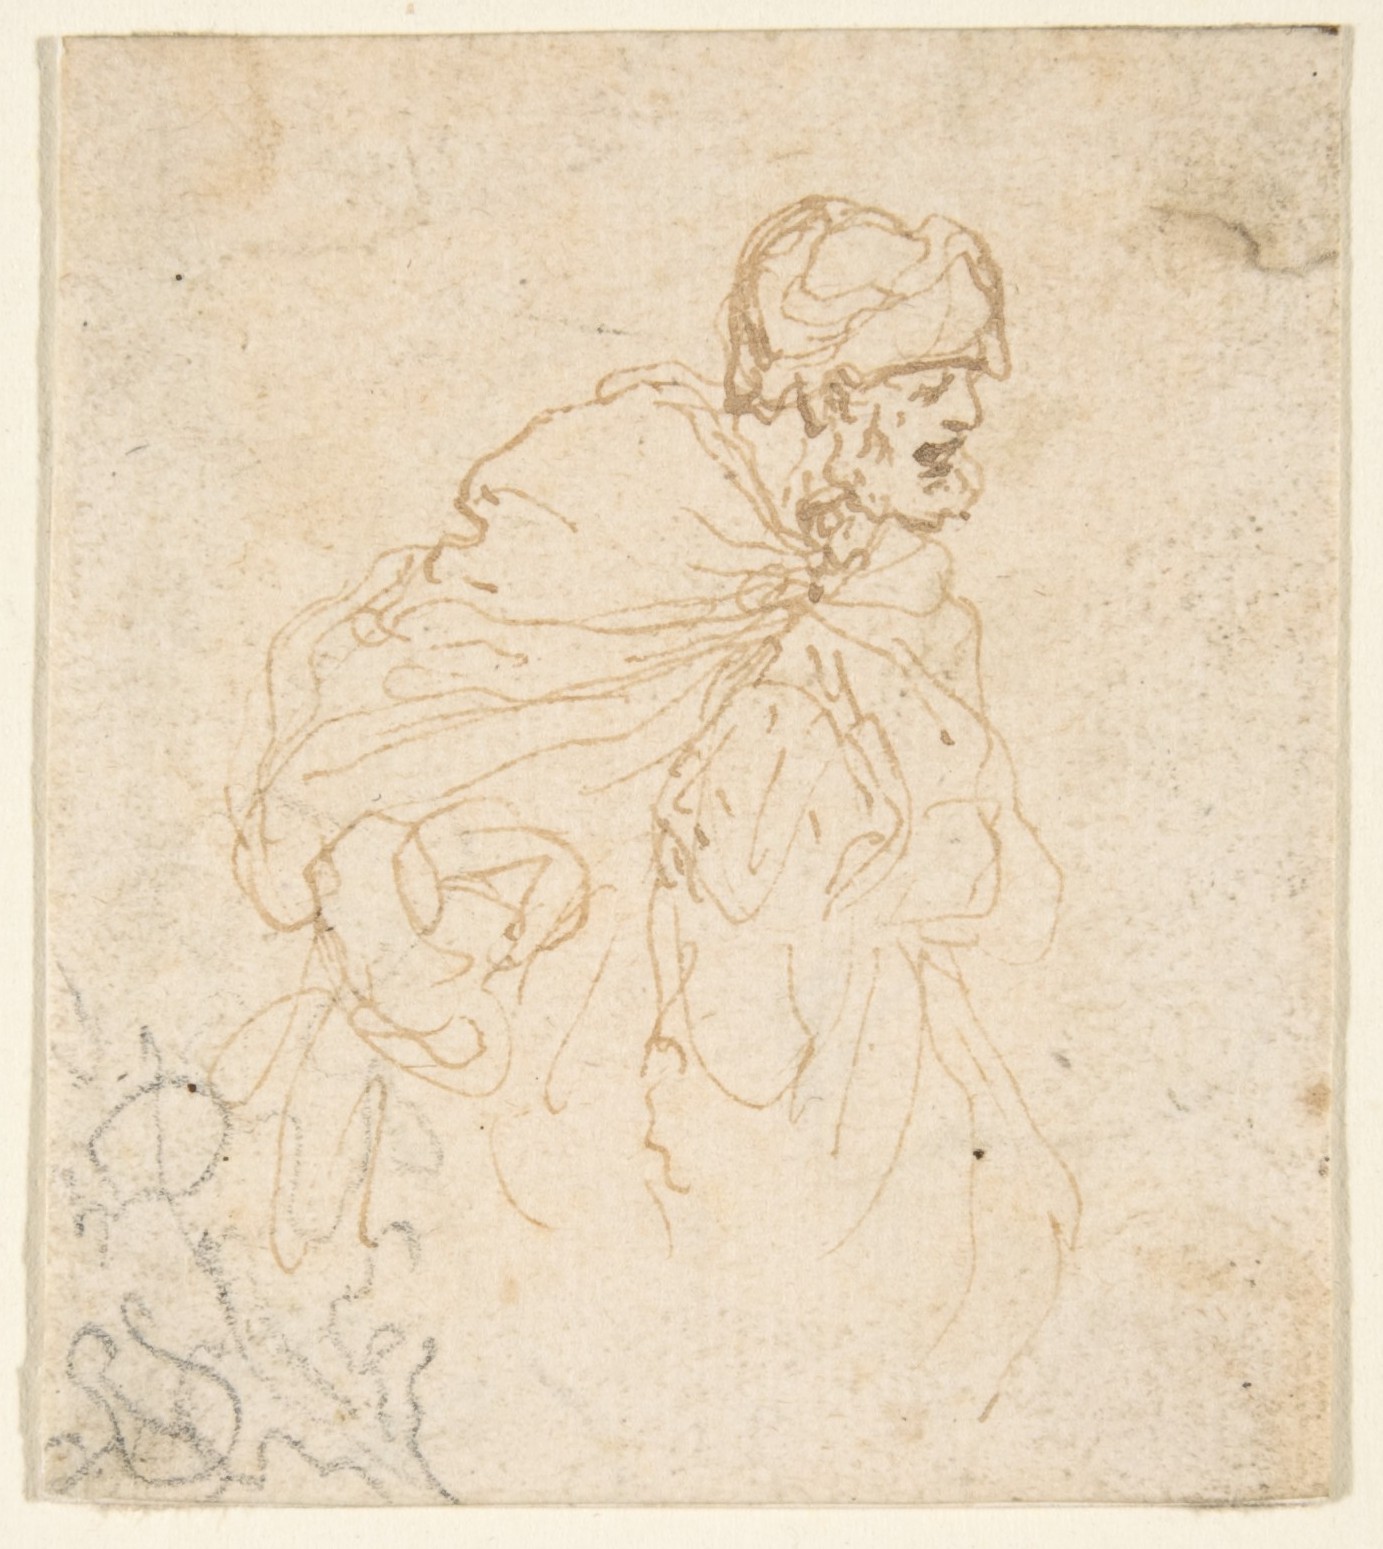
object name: drawing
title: A Bearded Man in a Cloak and Turban Facing Right.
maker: stefano della bella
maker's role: artist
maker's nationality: italian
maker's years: 1610-1664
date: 1610-1664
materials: graphite, ink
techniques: pen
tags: men